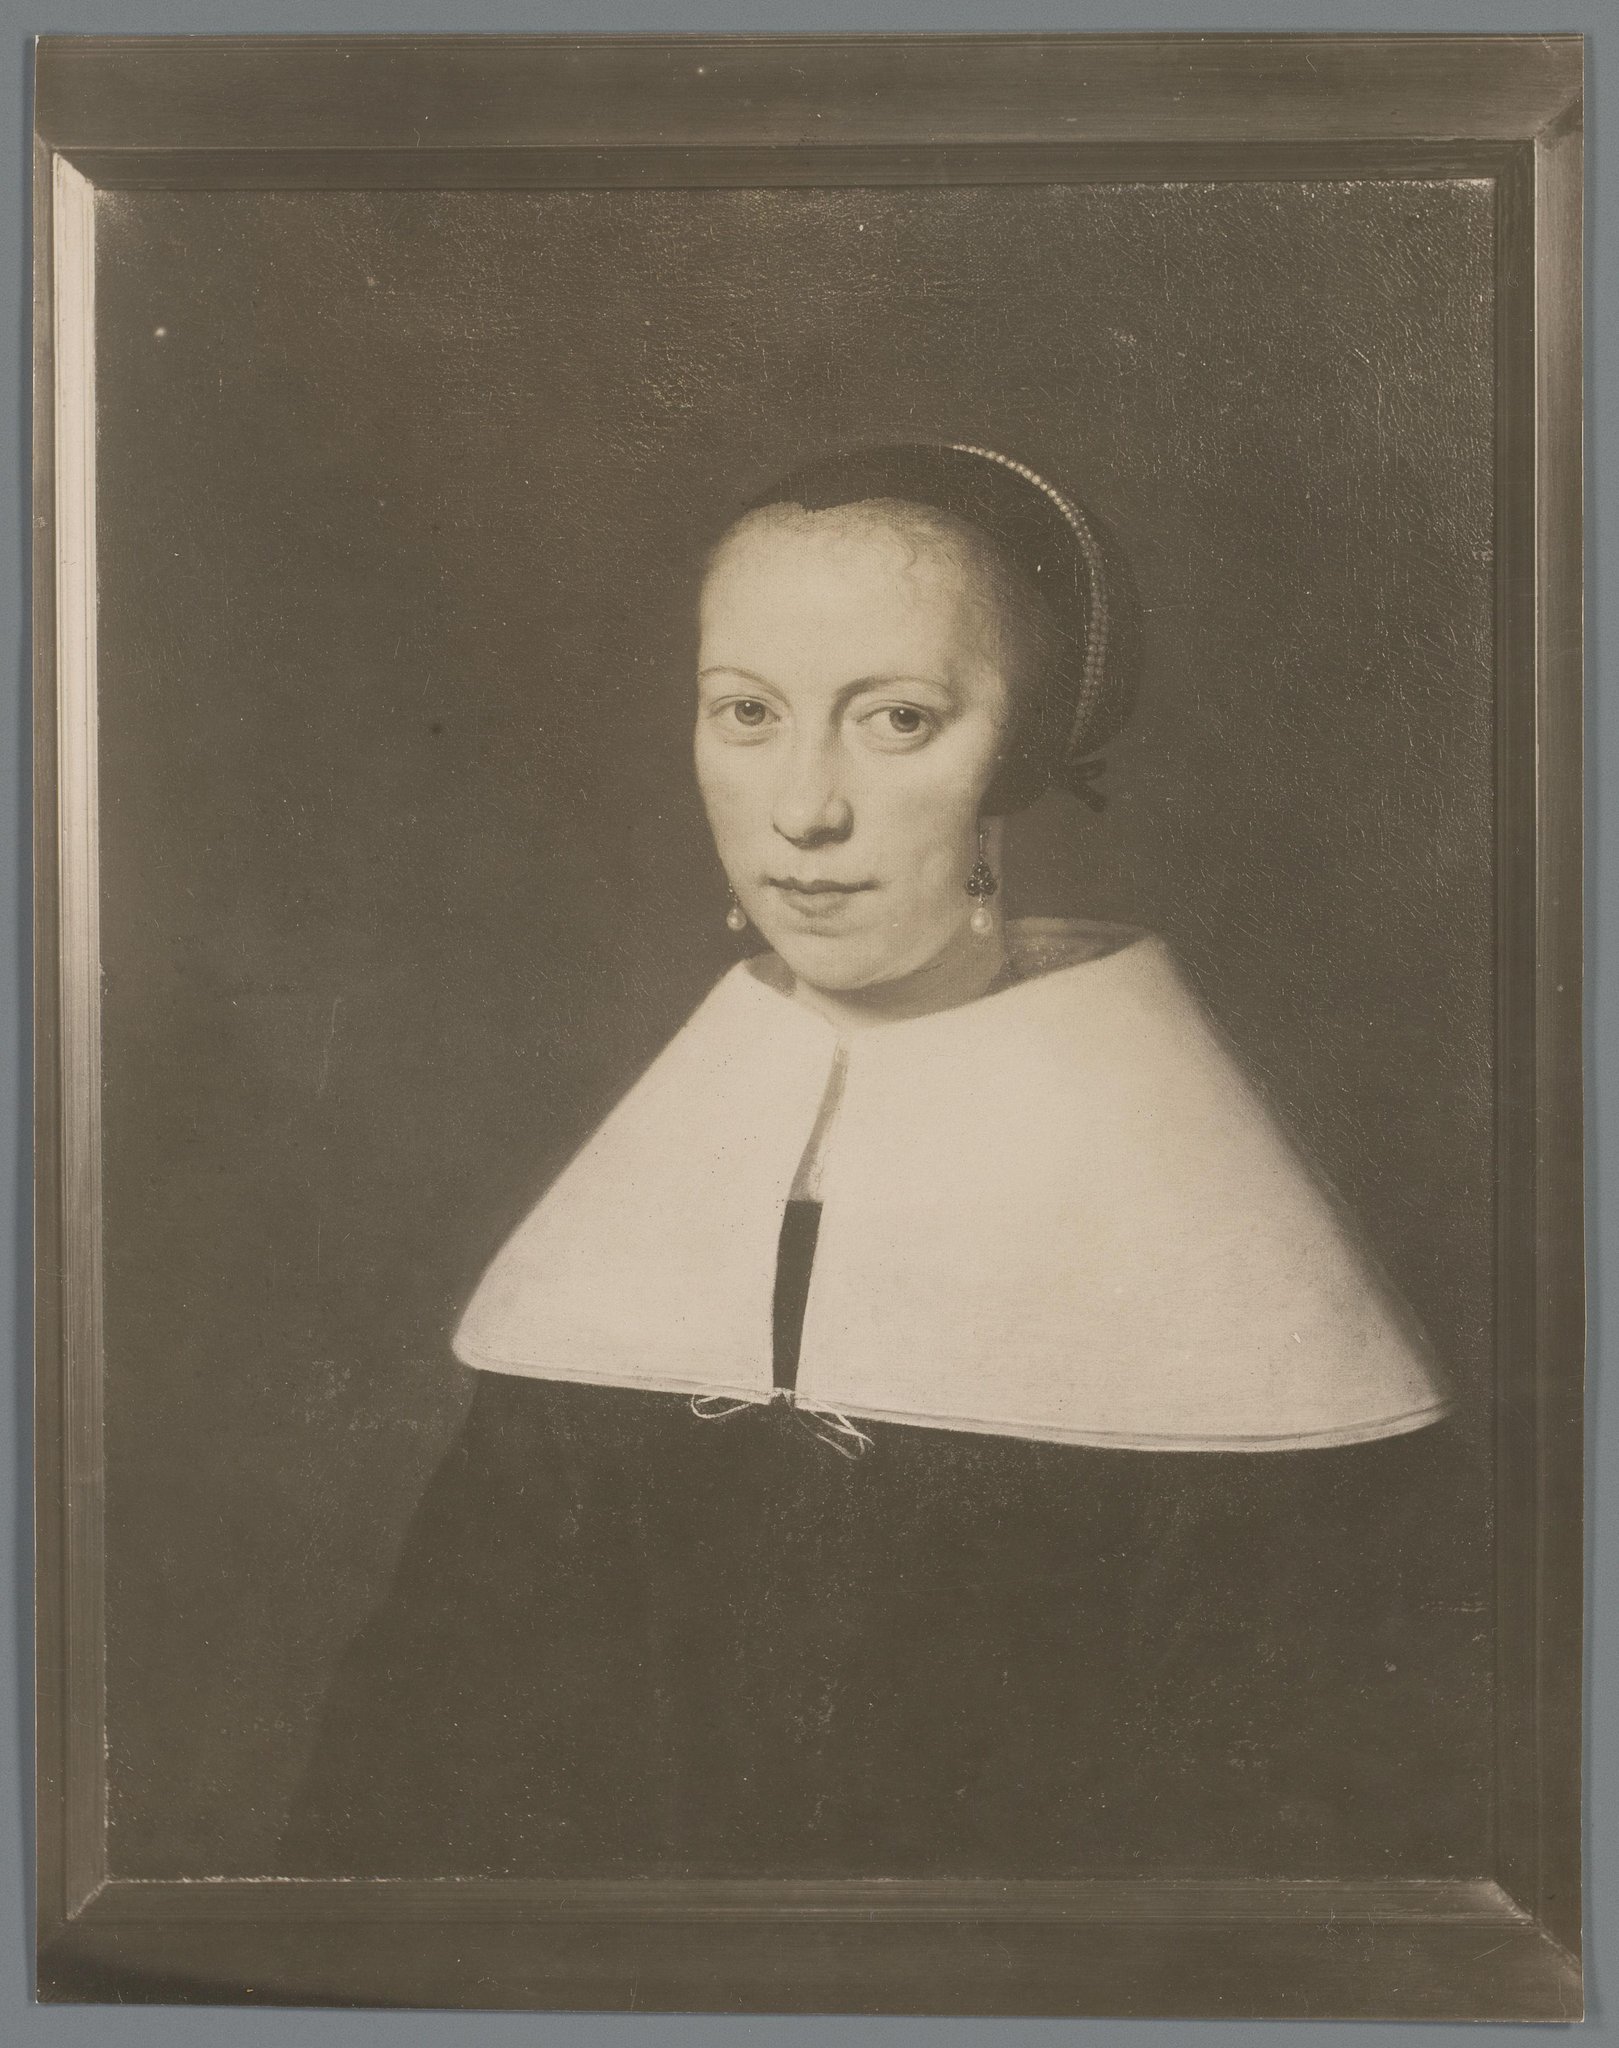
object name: photograph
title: Fotoreproductie van een geschilderd portret van een vrouw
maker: Anonymous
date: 1910-1990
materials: paper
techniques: gelatin silver print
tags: adult woman, historical persons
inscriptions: number: ‘No 499’